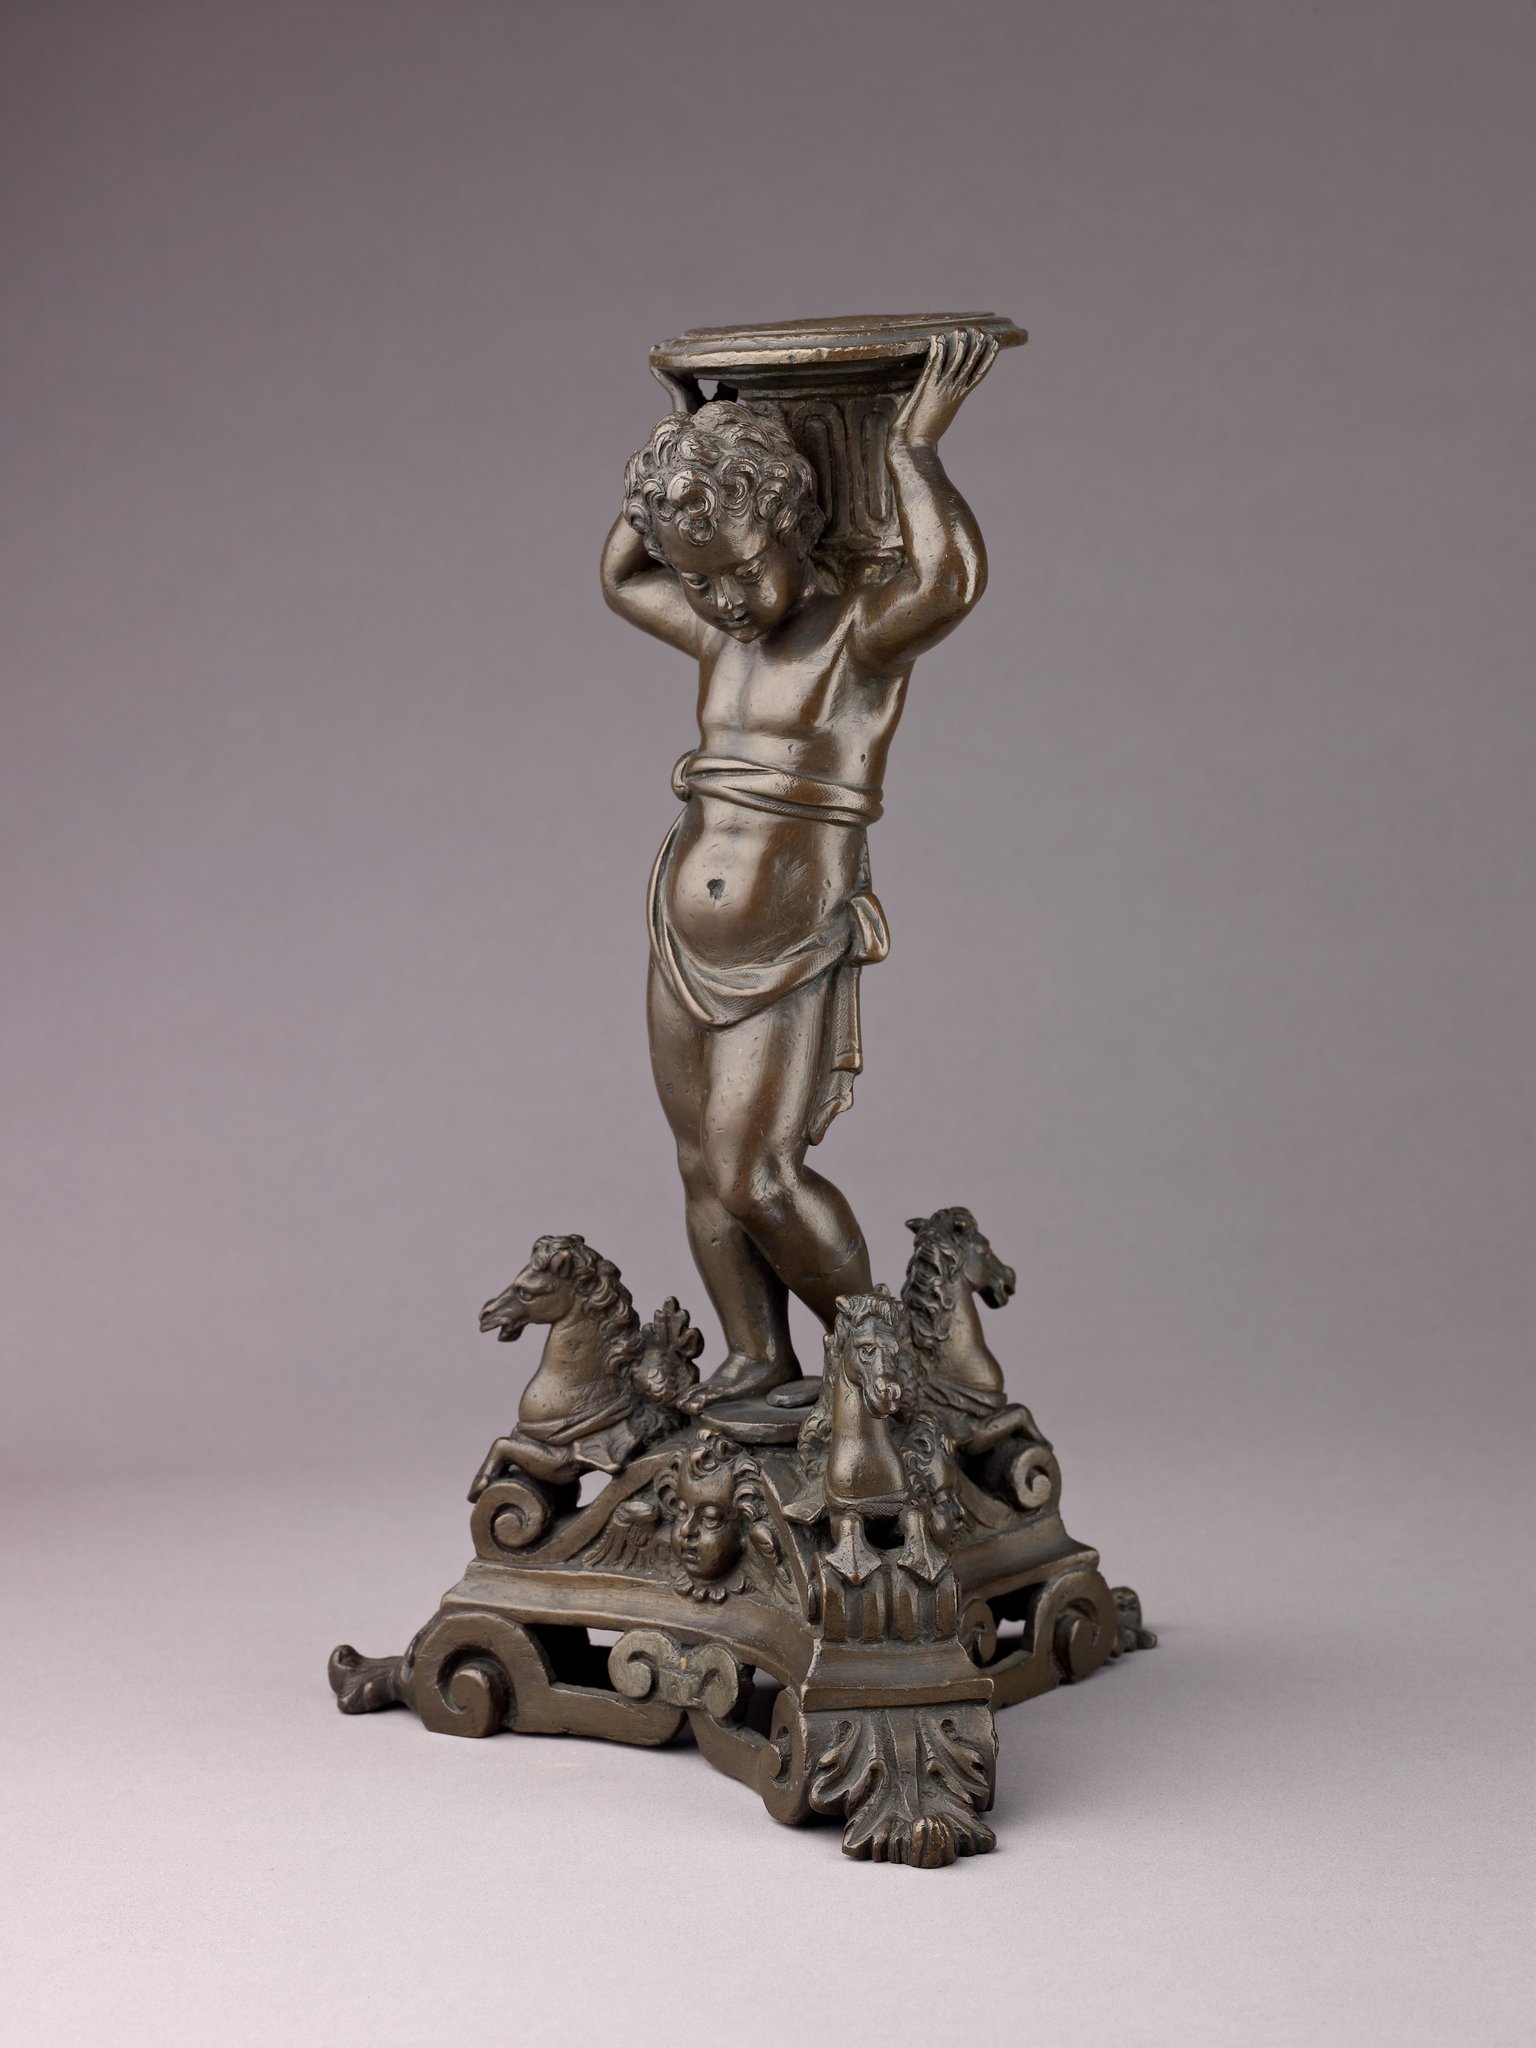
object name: candlestick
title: Candlestick in the form of a Putto (see also 1975.1.1375, .1376, .1377)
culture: italian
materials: bronze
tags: putti,horses